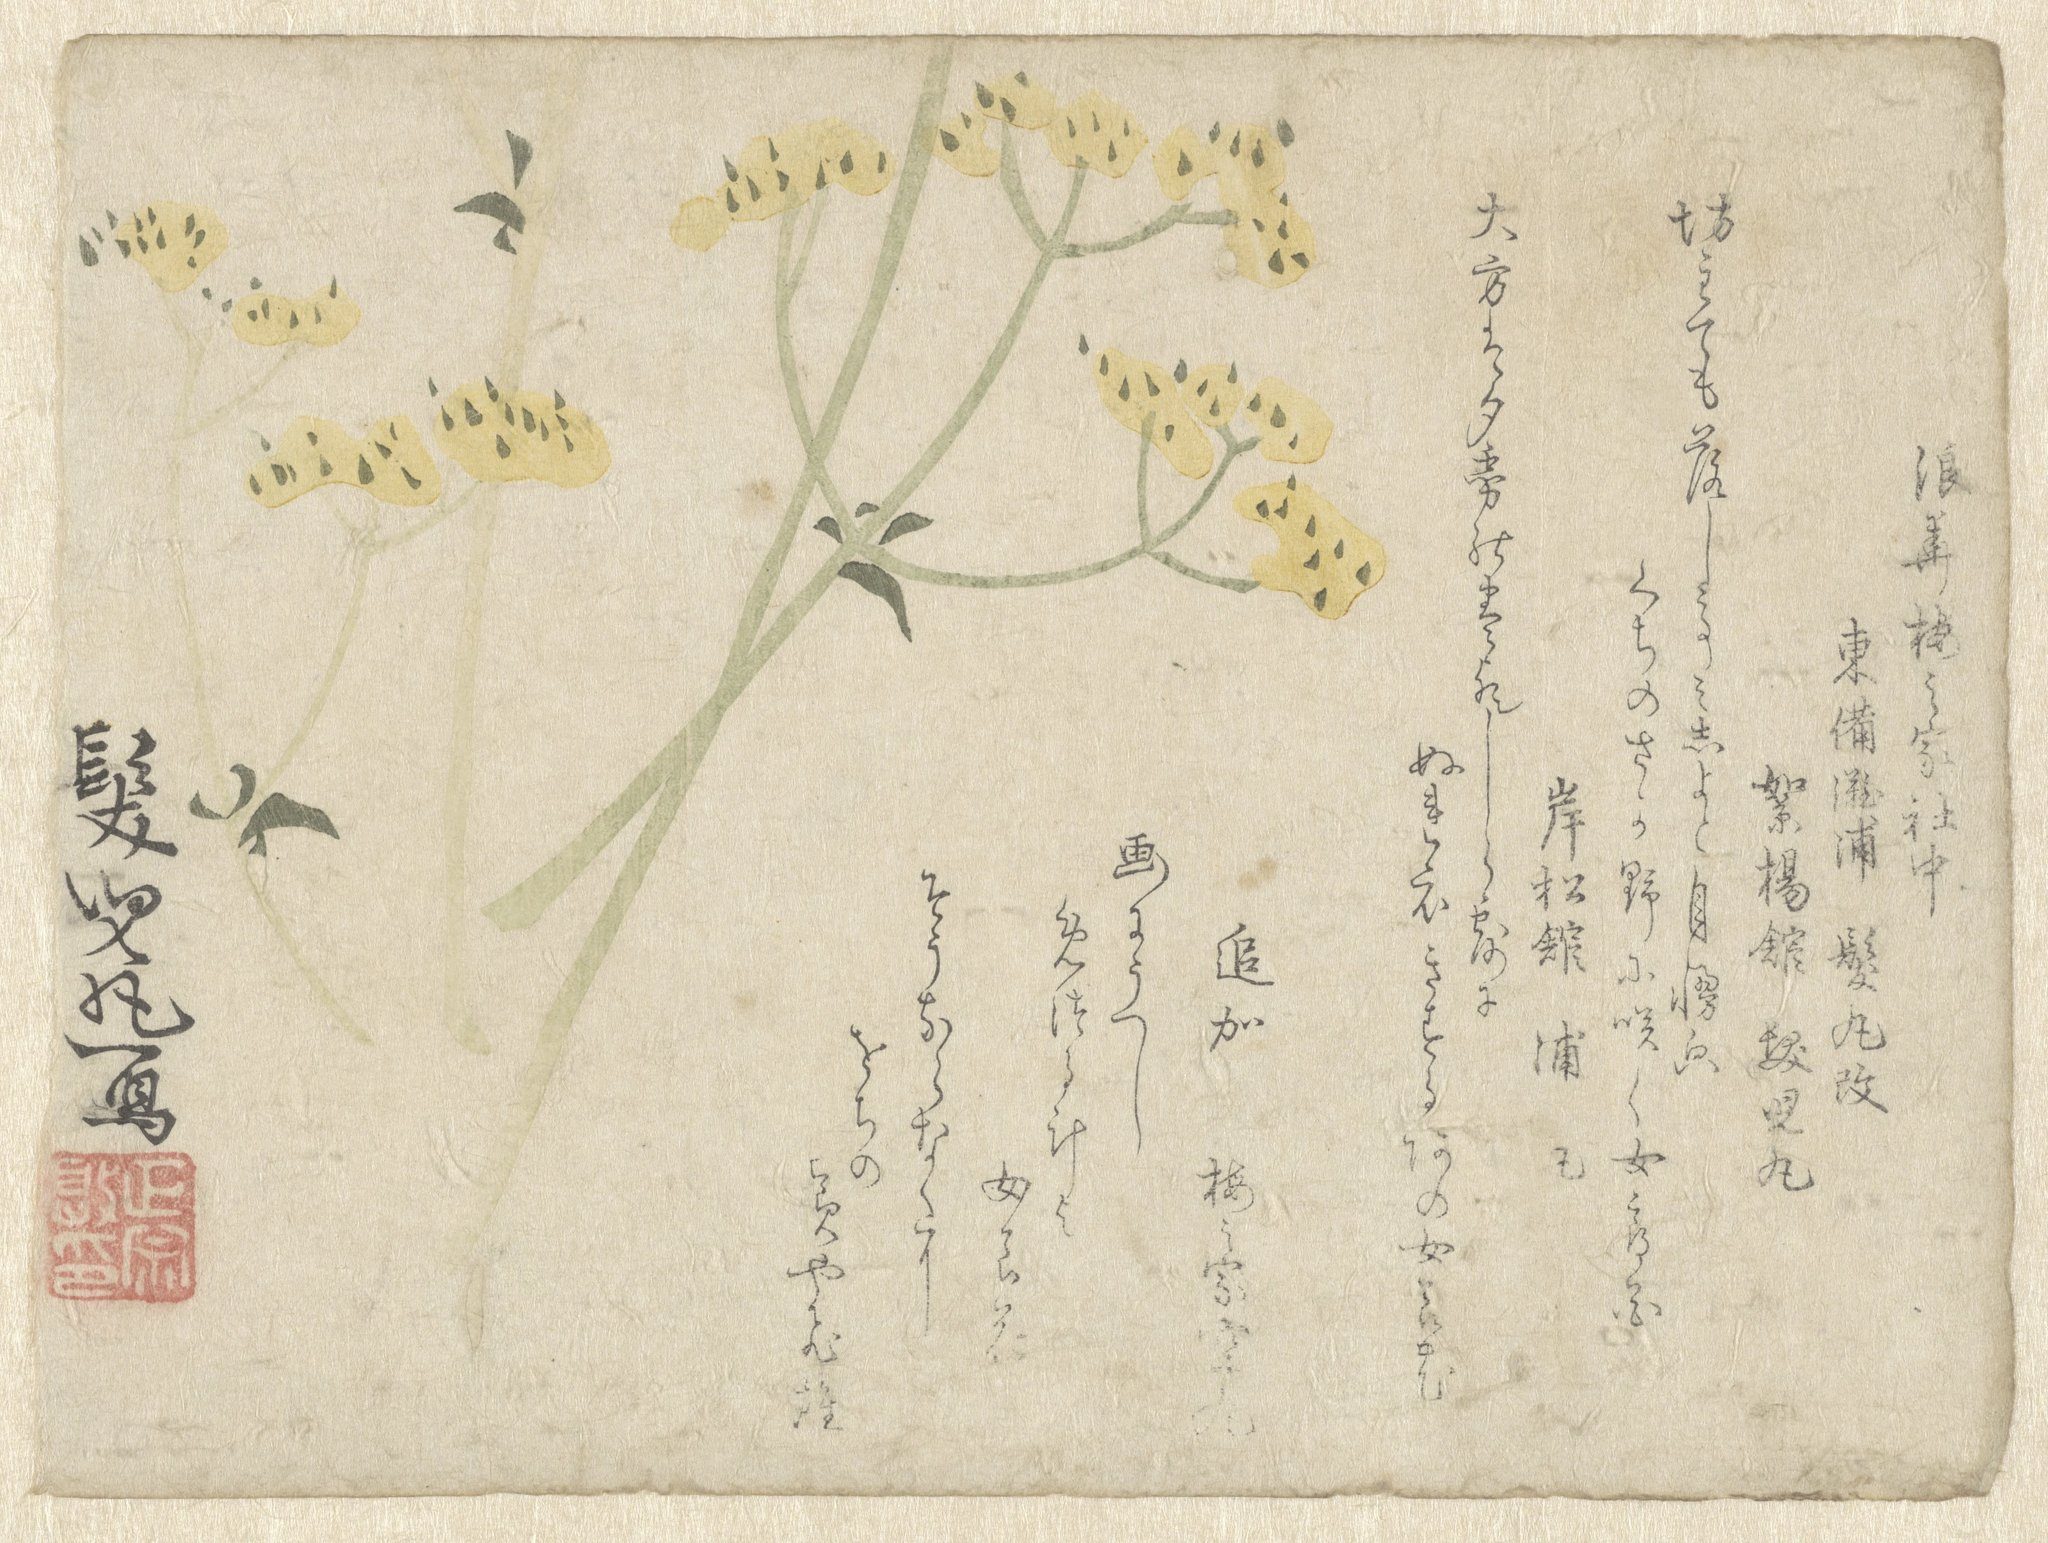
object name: surimono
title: Schermbloemen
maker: Anonymous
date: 1830-1840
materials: paper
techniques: woodcut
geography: japan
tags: flowers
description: Een surimono is een luxe uitgevoerde prent waarop beeld met één of meerdere gedichten gecombineerd is. Bij het drukken van een surimono werd vaak gebruik gemaakt van dikker papier, blinddruk en metaal pigmenten, zoals koper- en zilverpoeder. De prenten werden vaak in opdracht van dichters gemaakt en als exclusief geschenk aan vrienden en relaties gegeven.